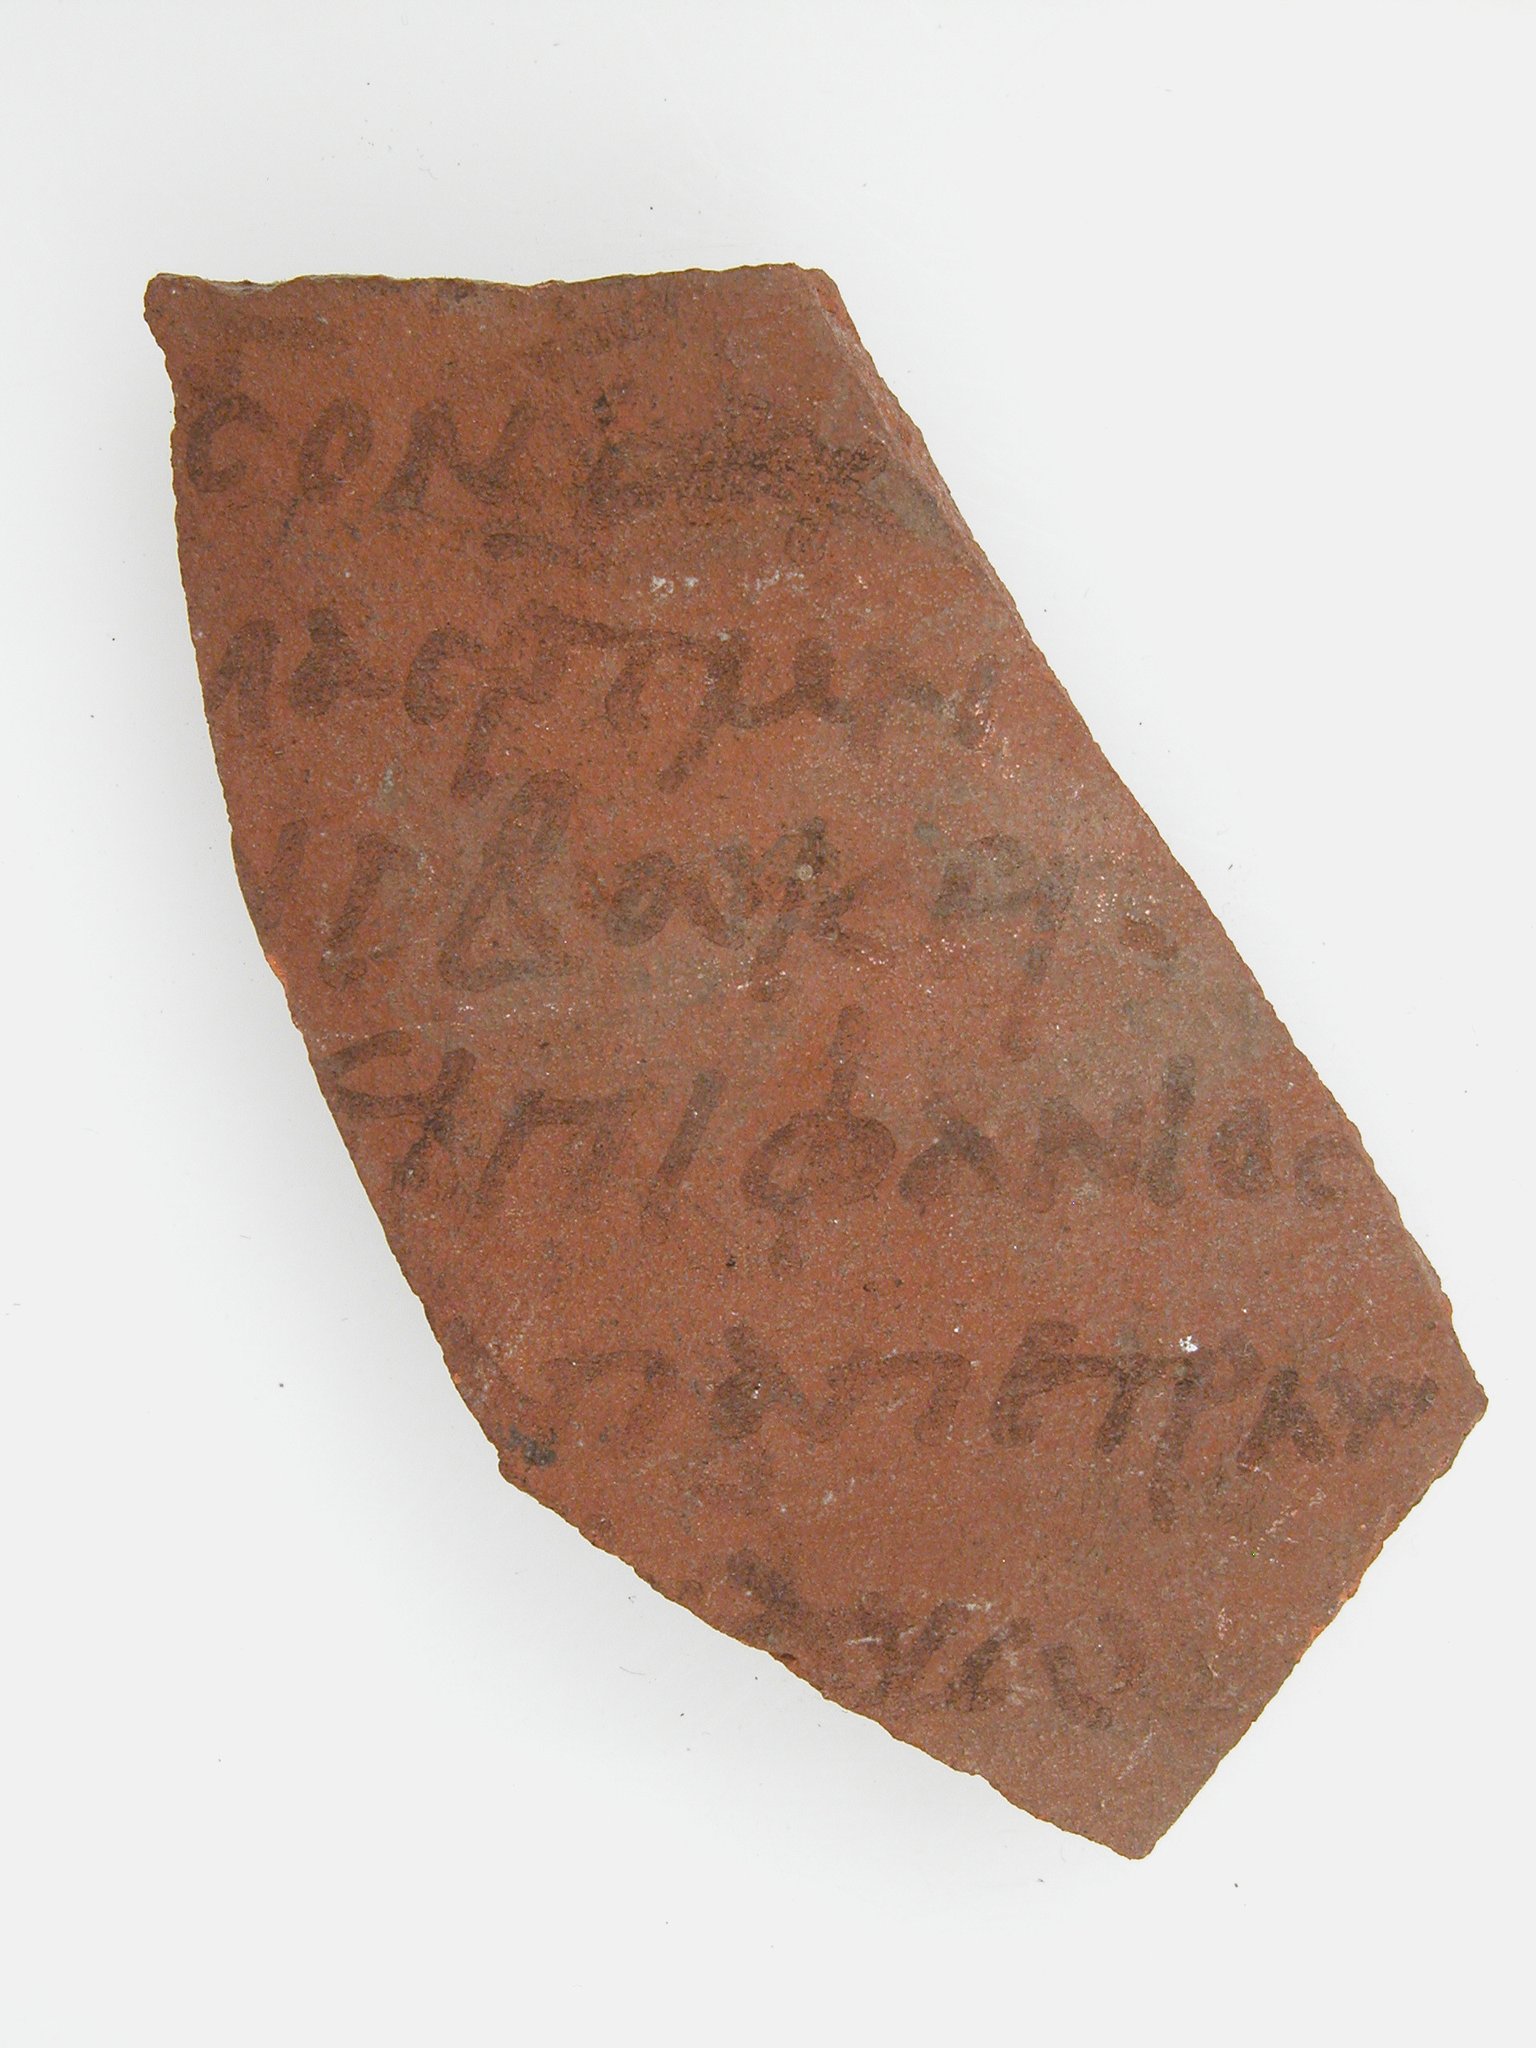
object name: ostrakon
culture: coptic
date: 601-700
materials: ink, pottery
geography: egypt